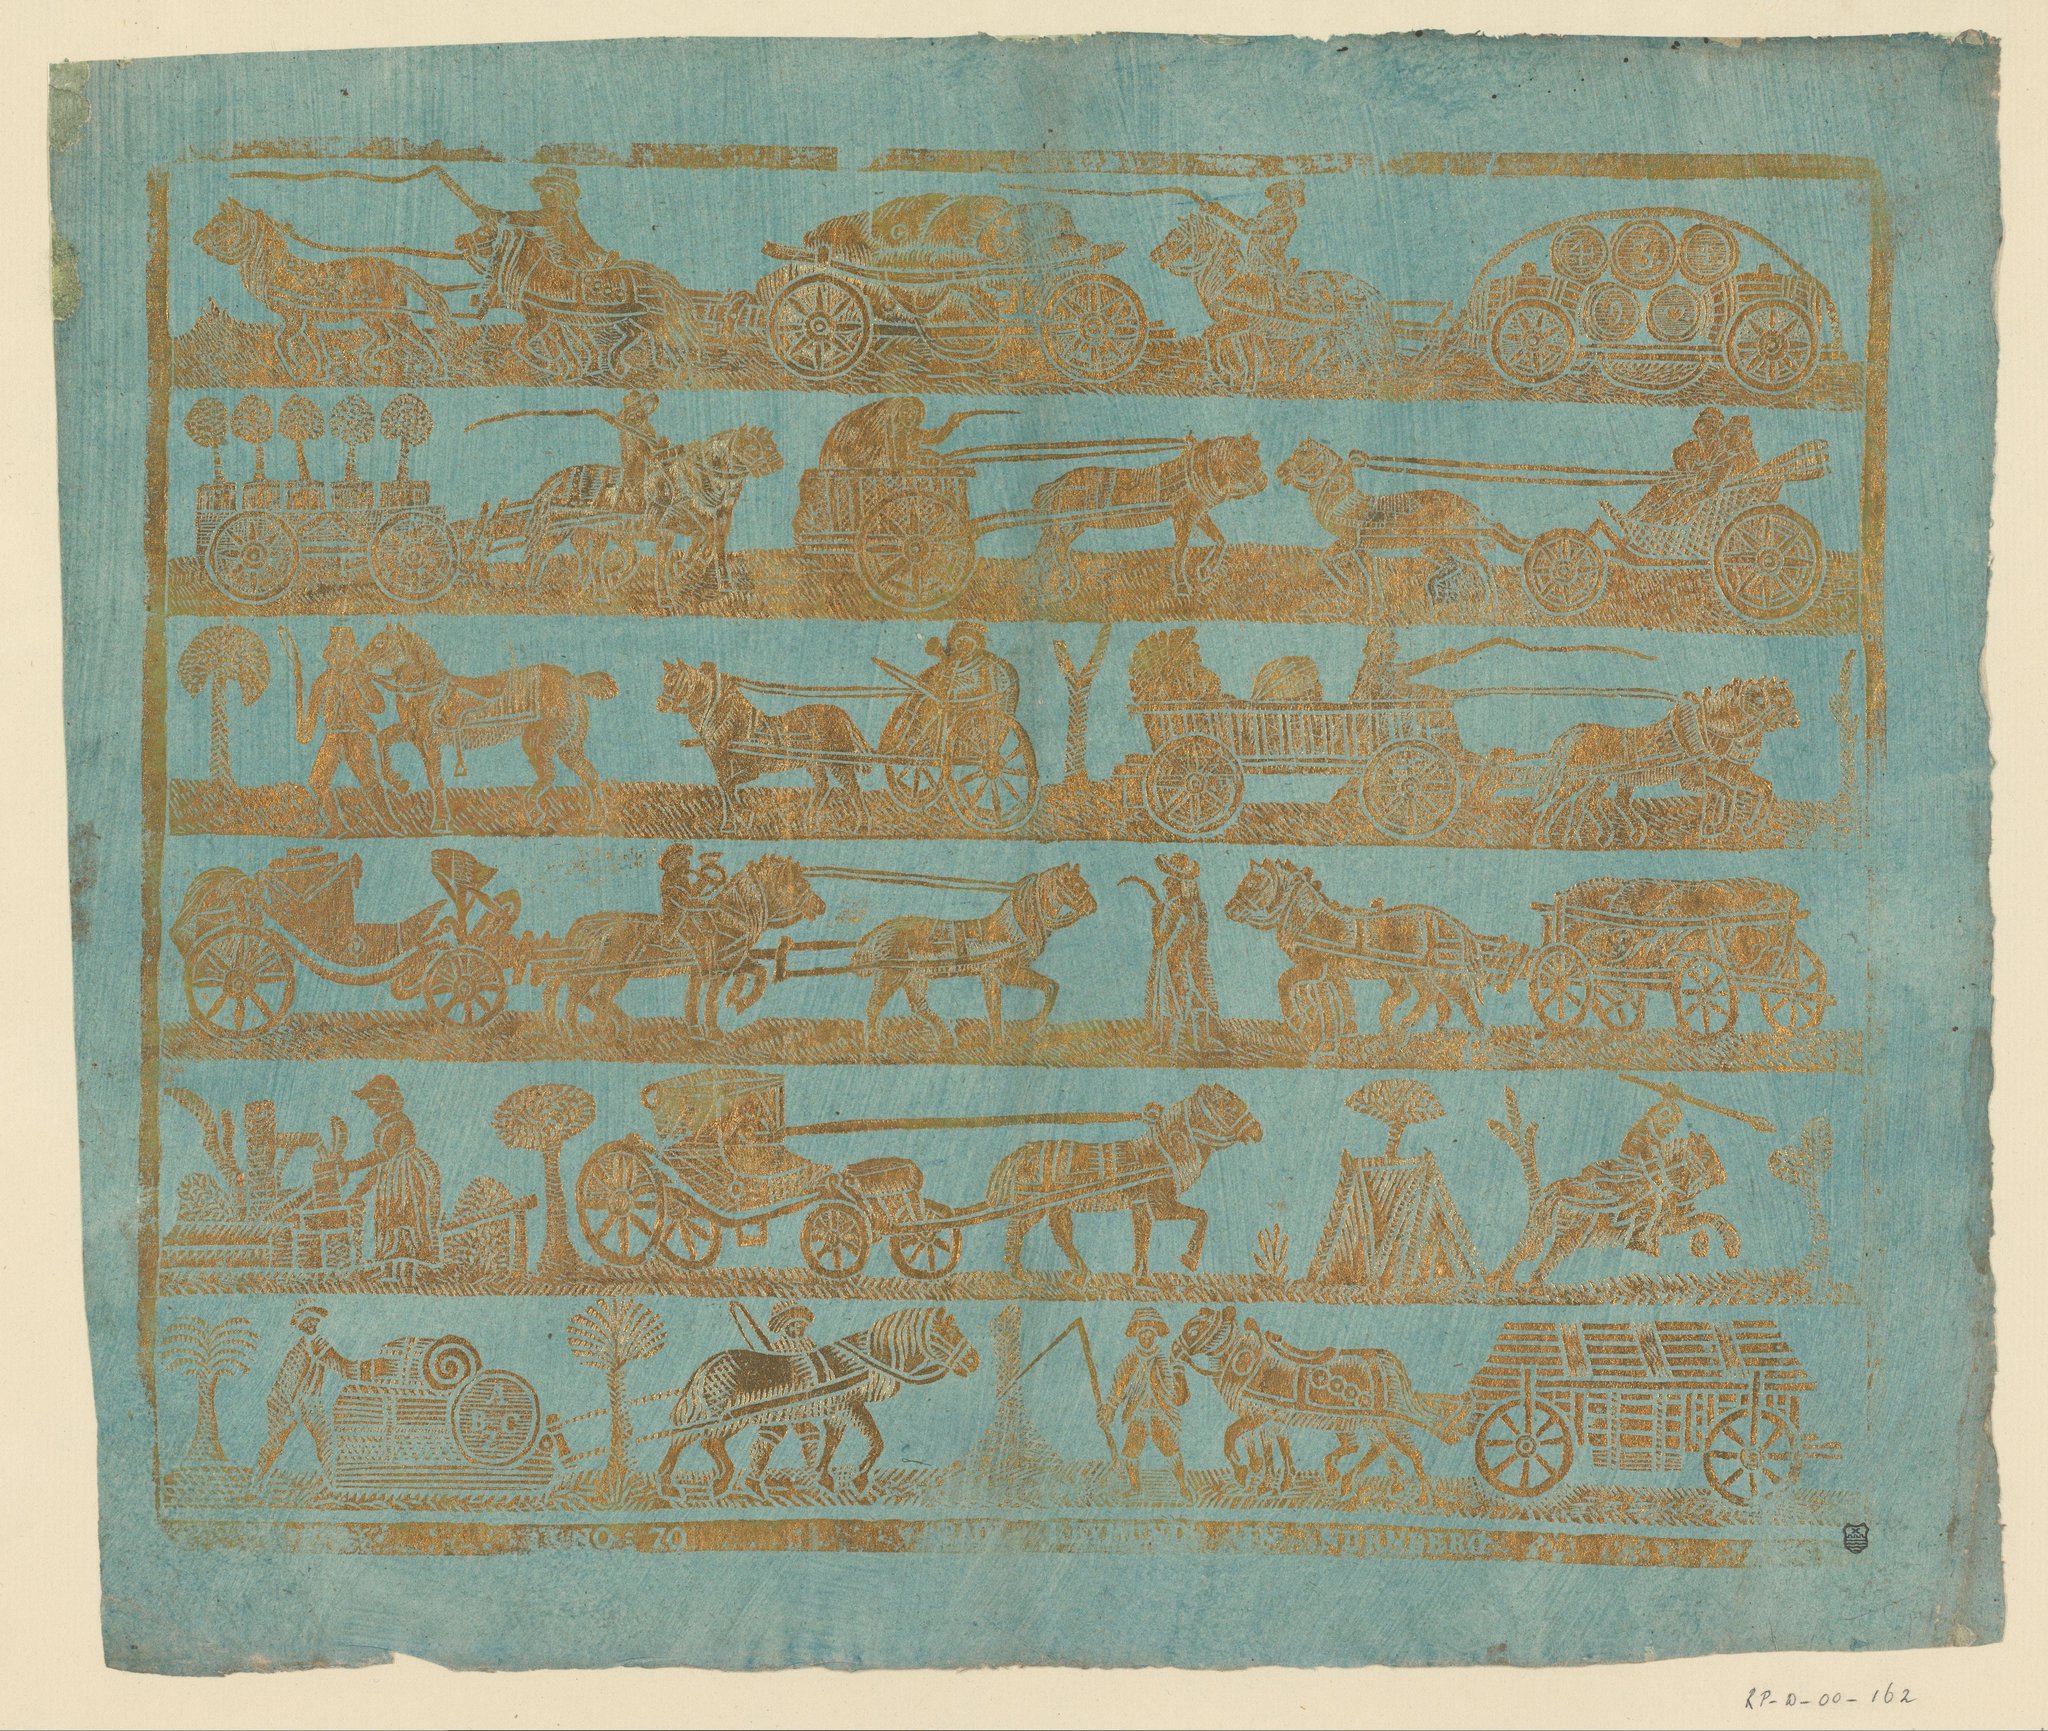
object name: brocade paper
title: Blad met zes rijen met verschillende voertuigen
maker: paul reimund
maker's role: sierpapiermaker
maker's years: 1764-1815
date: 1783-1815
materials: gold leaf, paint, paper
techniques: relief print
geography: nuremberg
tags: two-wheeled, animal-drawn vehicle, four-wheeled, animal-drawn vehicle, e.g.: cab, carriage, coach, animal-drawn sledge (dutch: 'toeslede')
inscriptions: collector's mark: Lugt 2760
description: Blad met zes rijen met verschillende door paarden getrokken voertuigen. Onderaan genummerd: 70.